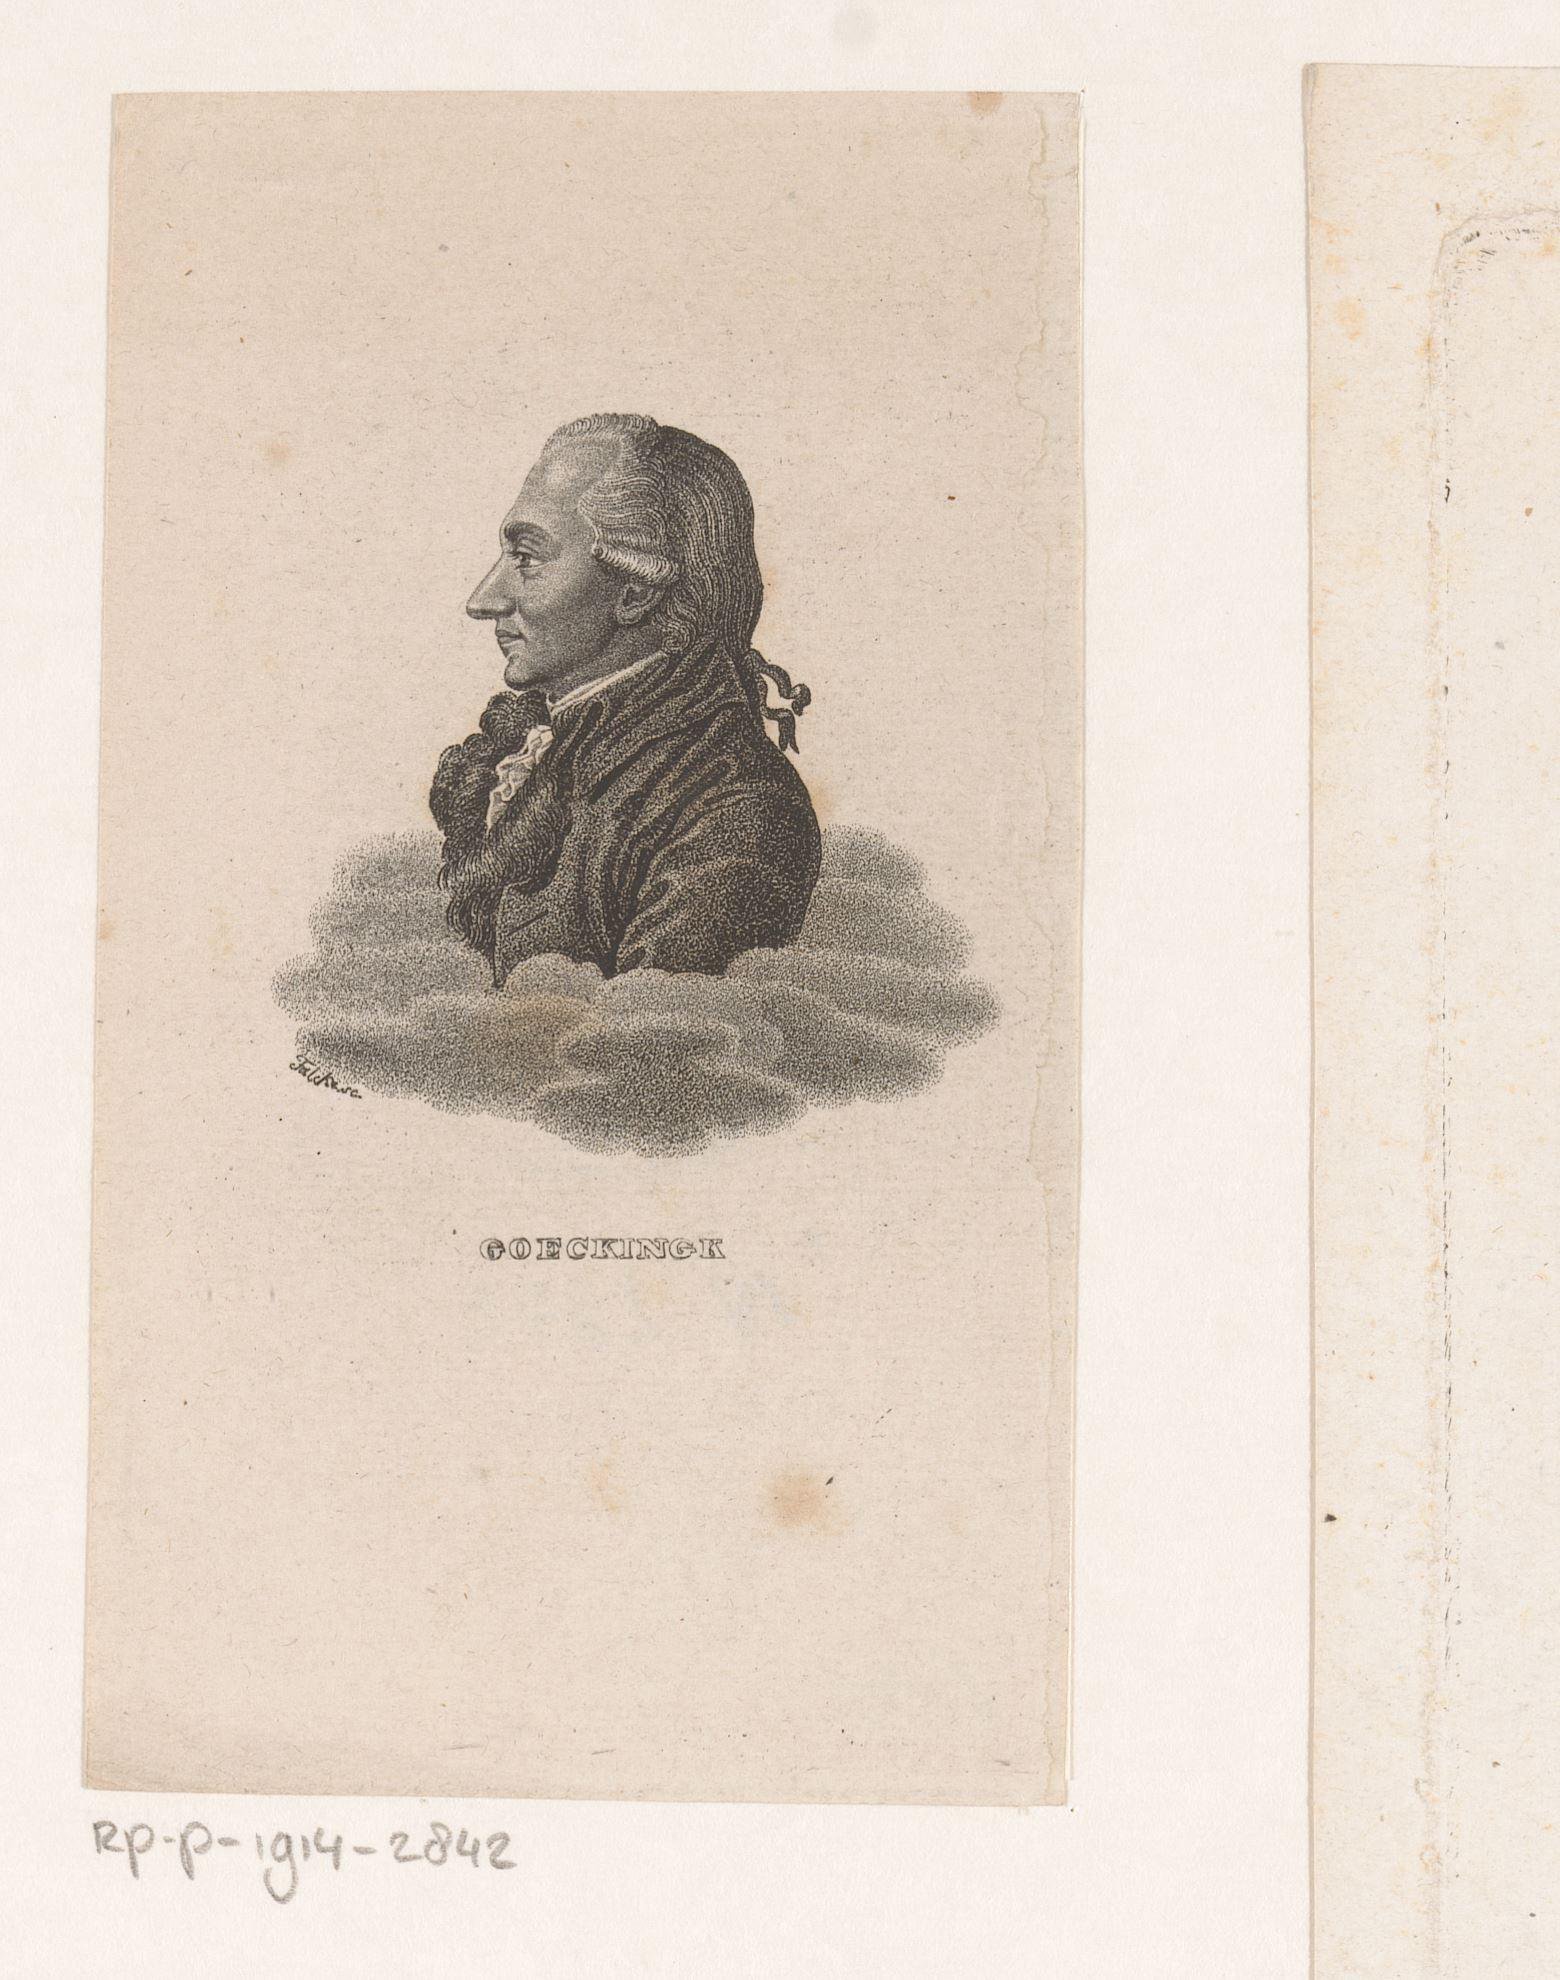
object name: print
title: Portret van Leopold Friedrich Günther von Goeckingk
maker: tobias falke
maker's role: print maker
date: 1800-1830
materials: paper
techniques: stippling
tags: clouds, historical persons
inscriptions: collector's mark: Lugt 2228